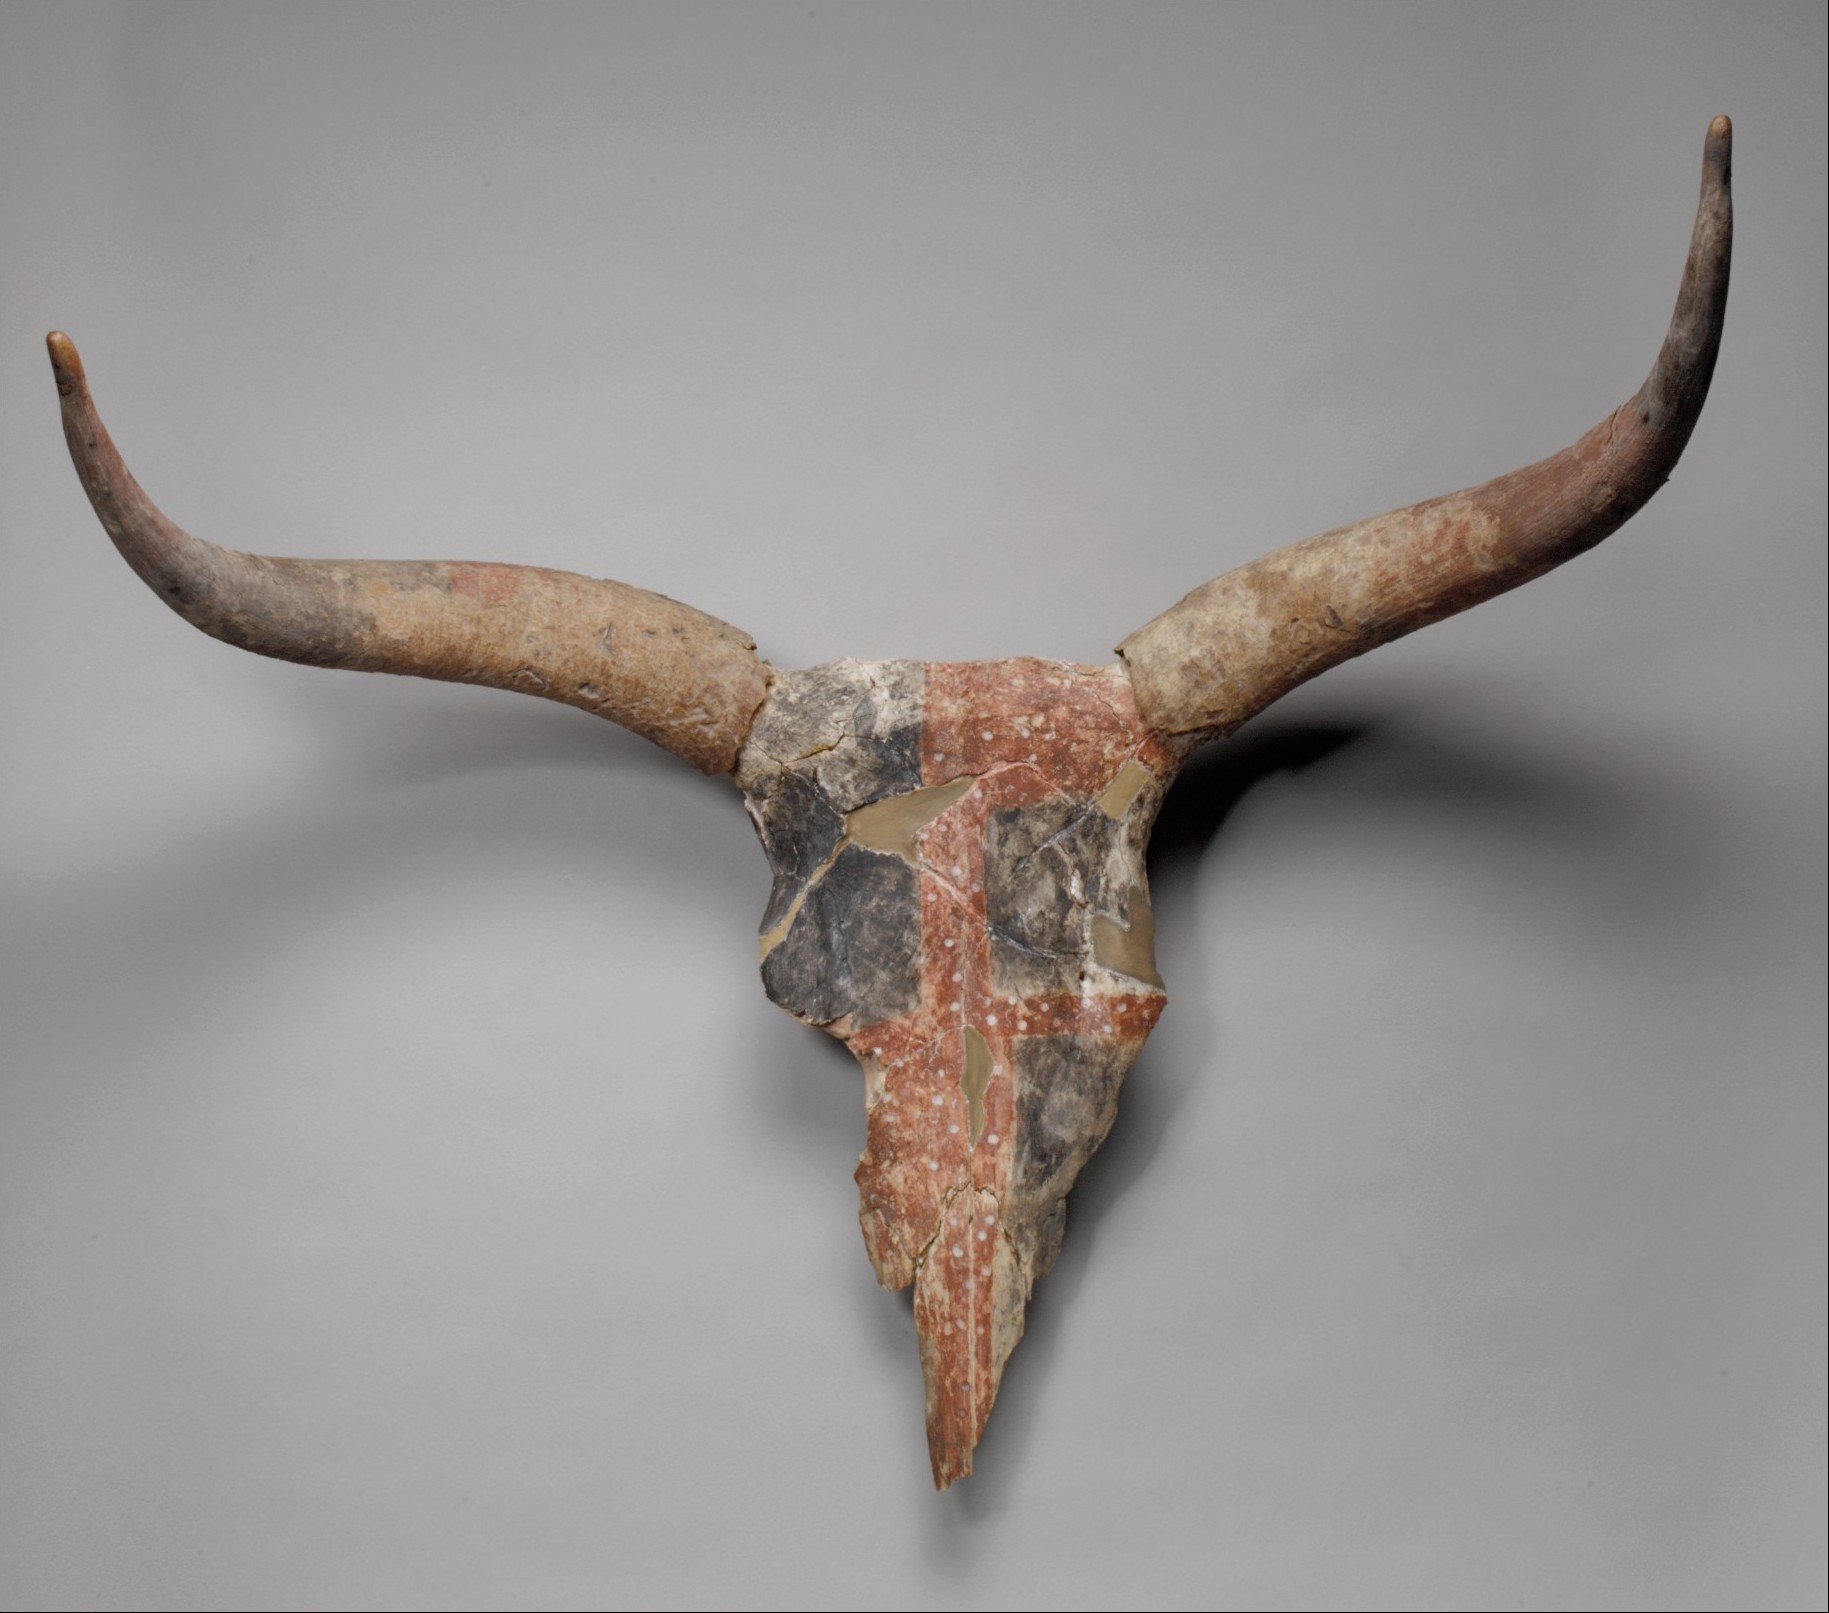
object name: bucranium, antler, horn, pan grave, medjayu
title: Bucranium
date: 1640-1550 BCE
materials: bone, horn, paint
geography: egypt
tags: animals